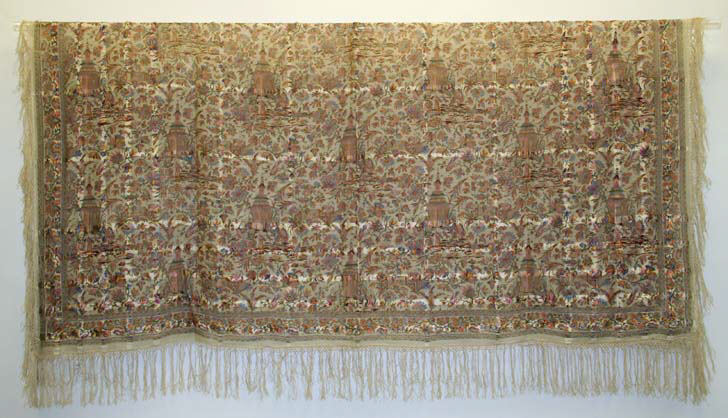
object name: shawl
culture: european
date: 1850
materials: silk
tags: men